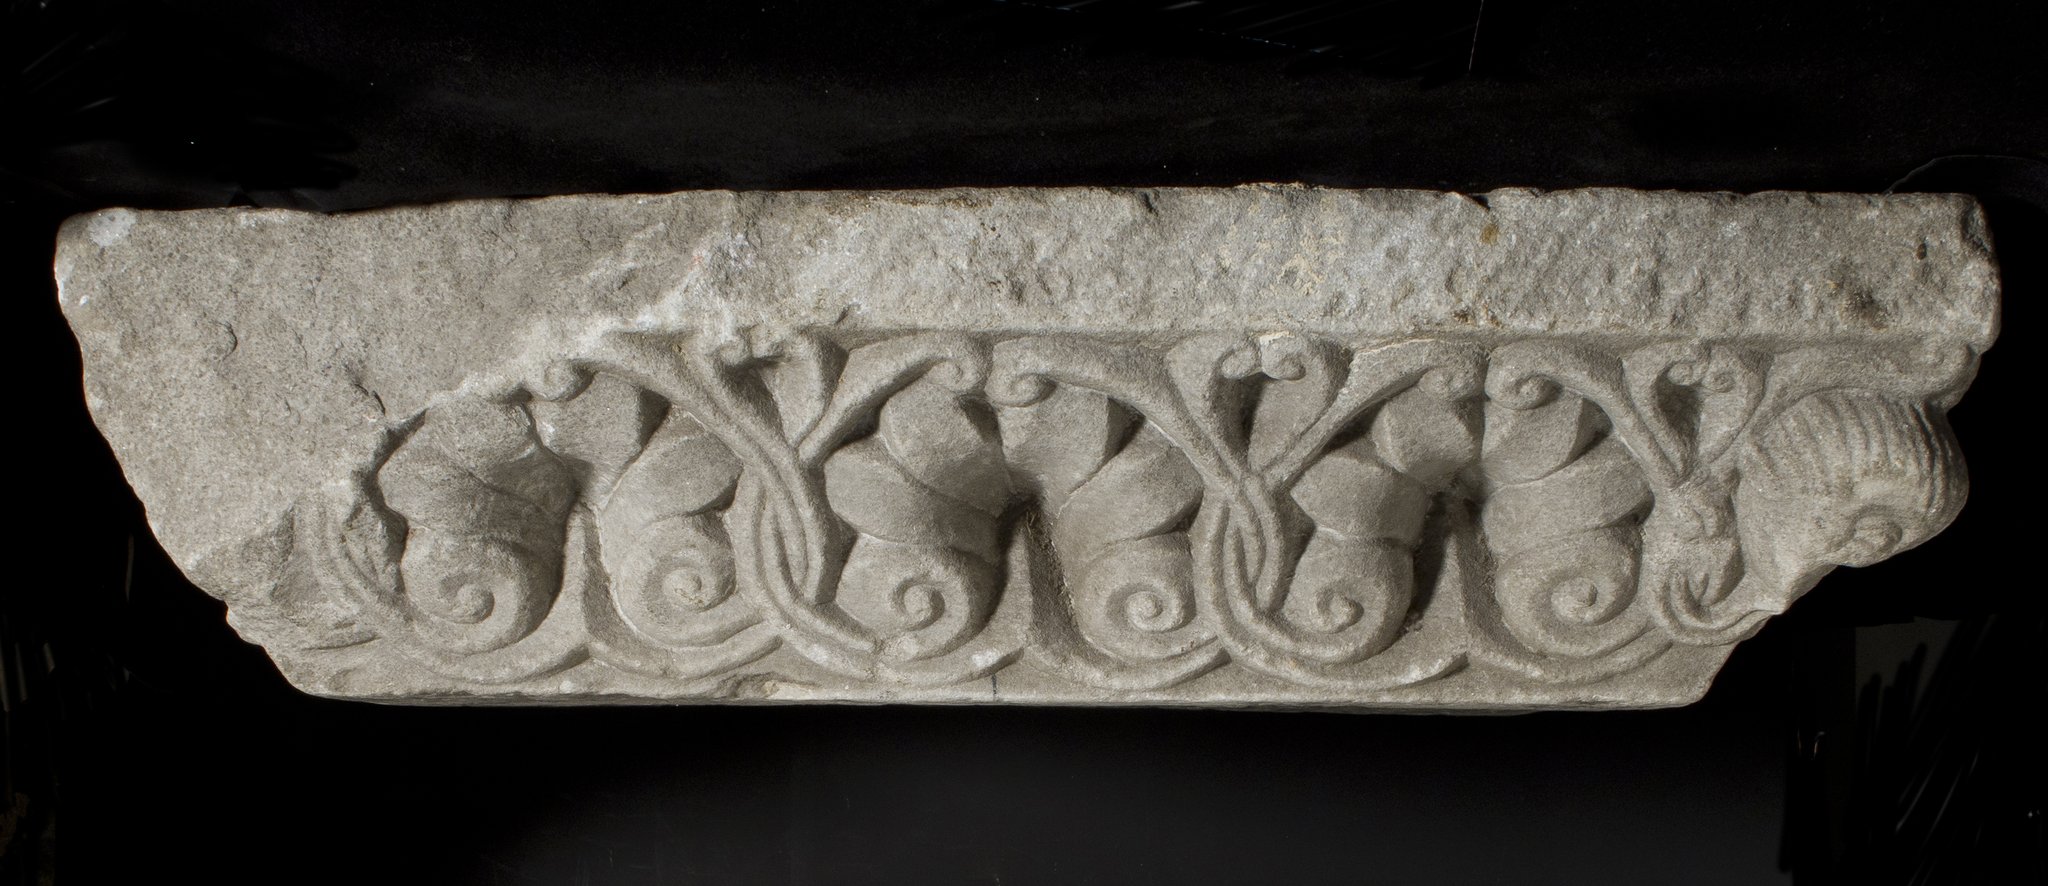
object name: abacus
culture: catalan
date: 1130-1140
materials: marble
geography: france